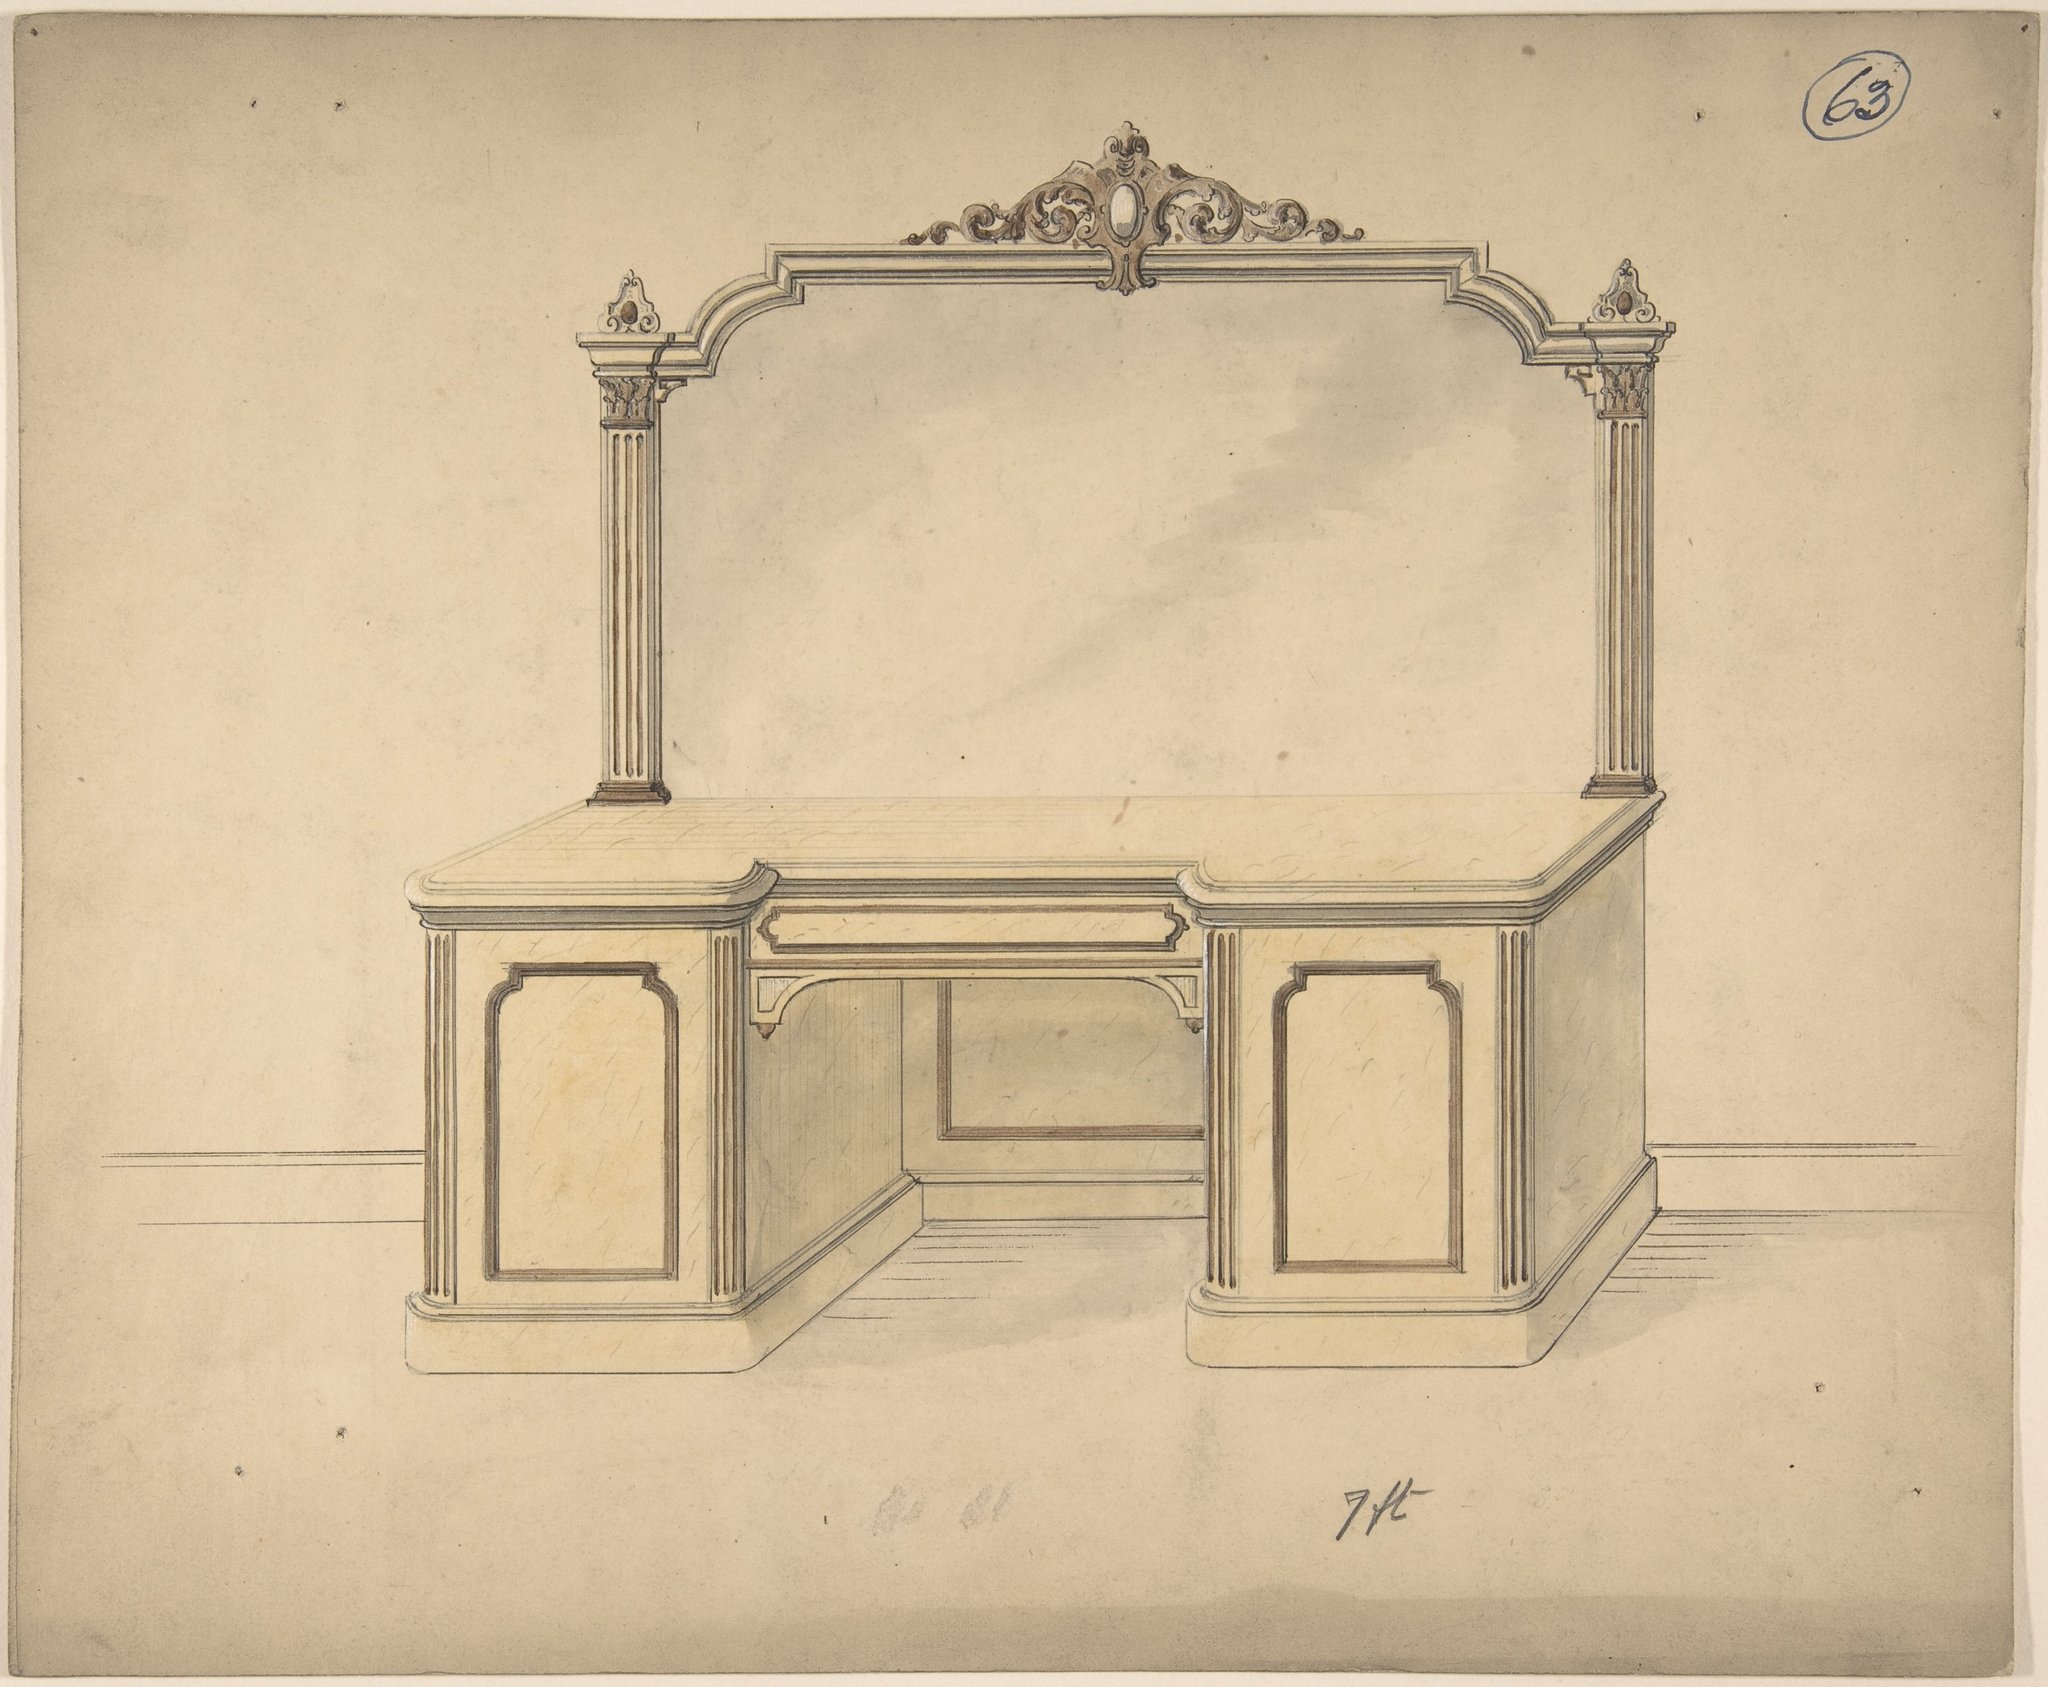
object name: drawing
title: Design for a Desk with Mirror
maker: charles hindley and sons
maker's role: artist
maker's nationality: british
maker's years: 1841-1917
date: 1841-1884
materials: gouache, graphite, watercolor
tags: desks,mirrors